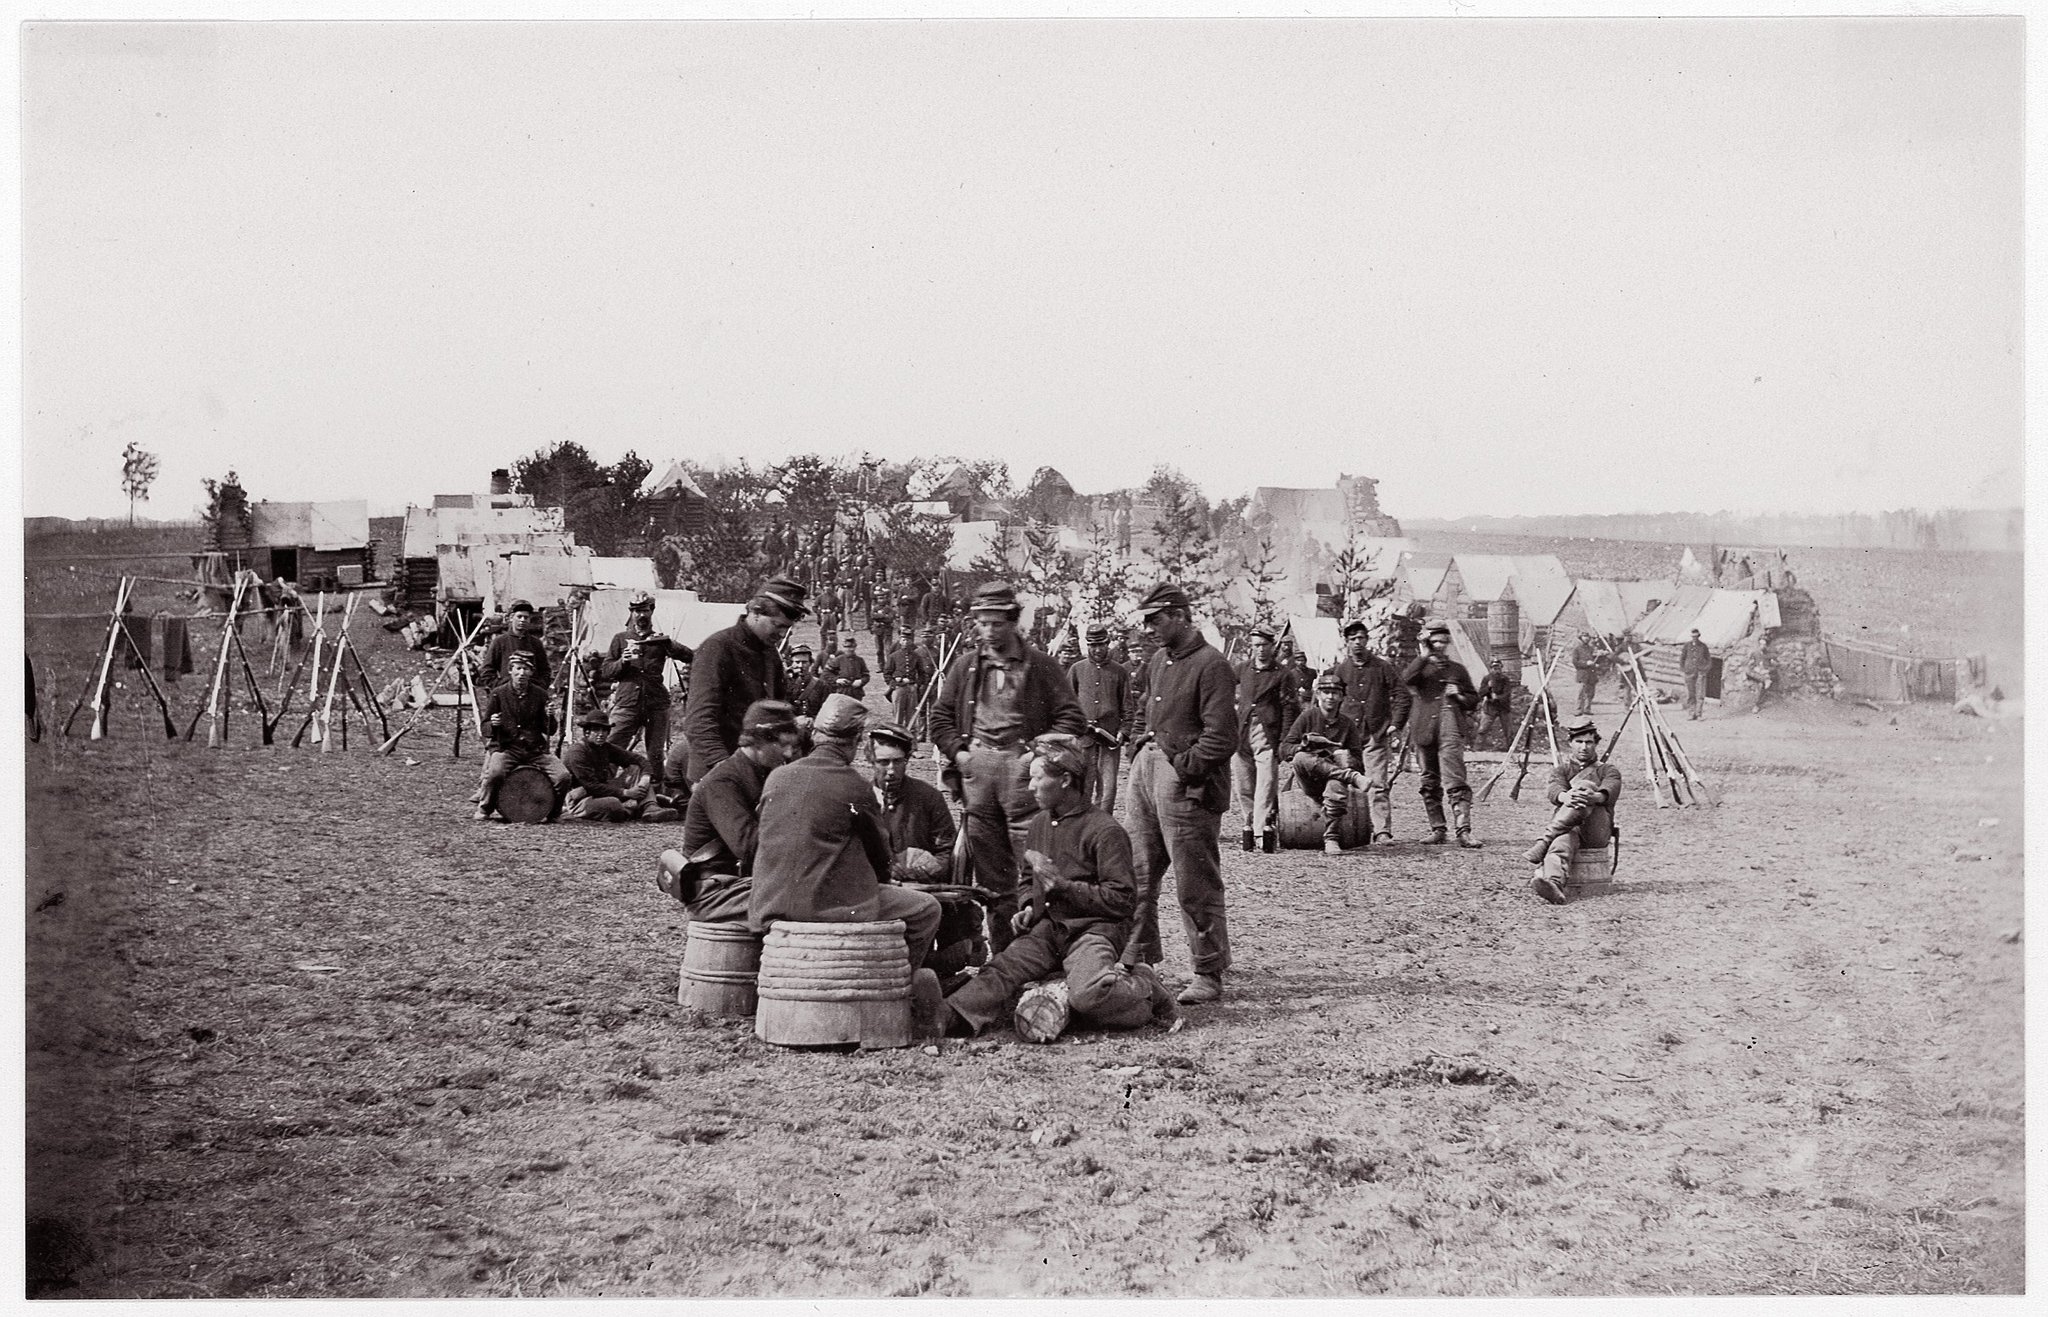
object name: photograph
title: [Playing Cards, Winter Quarters]. Brady album, p. 129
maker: Anonymous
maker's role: artist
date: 1861-1865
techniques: albumen silver print, glass negative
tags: army,soldiers,american civil war